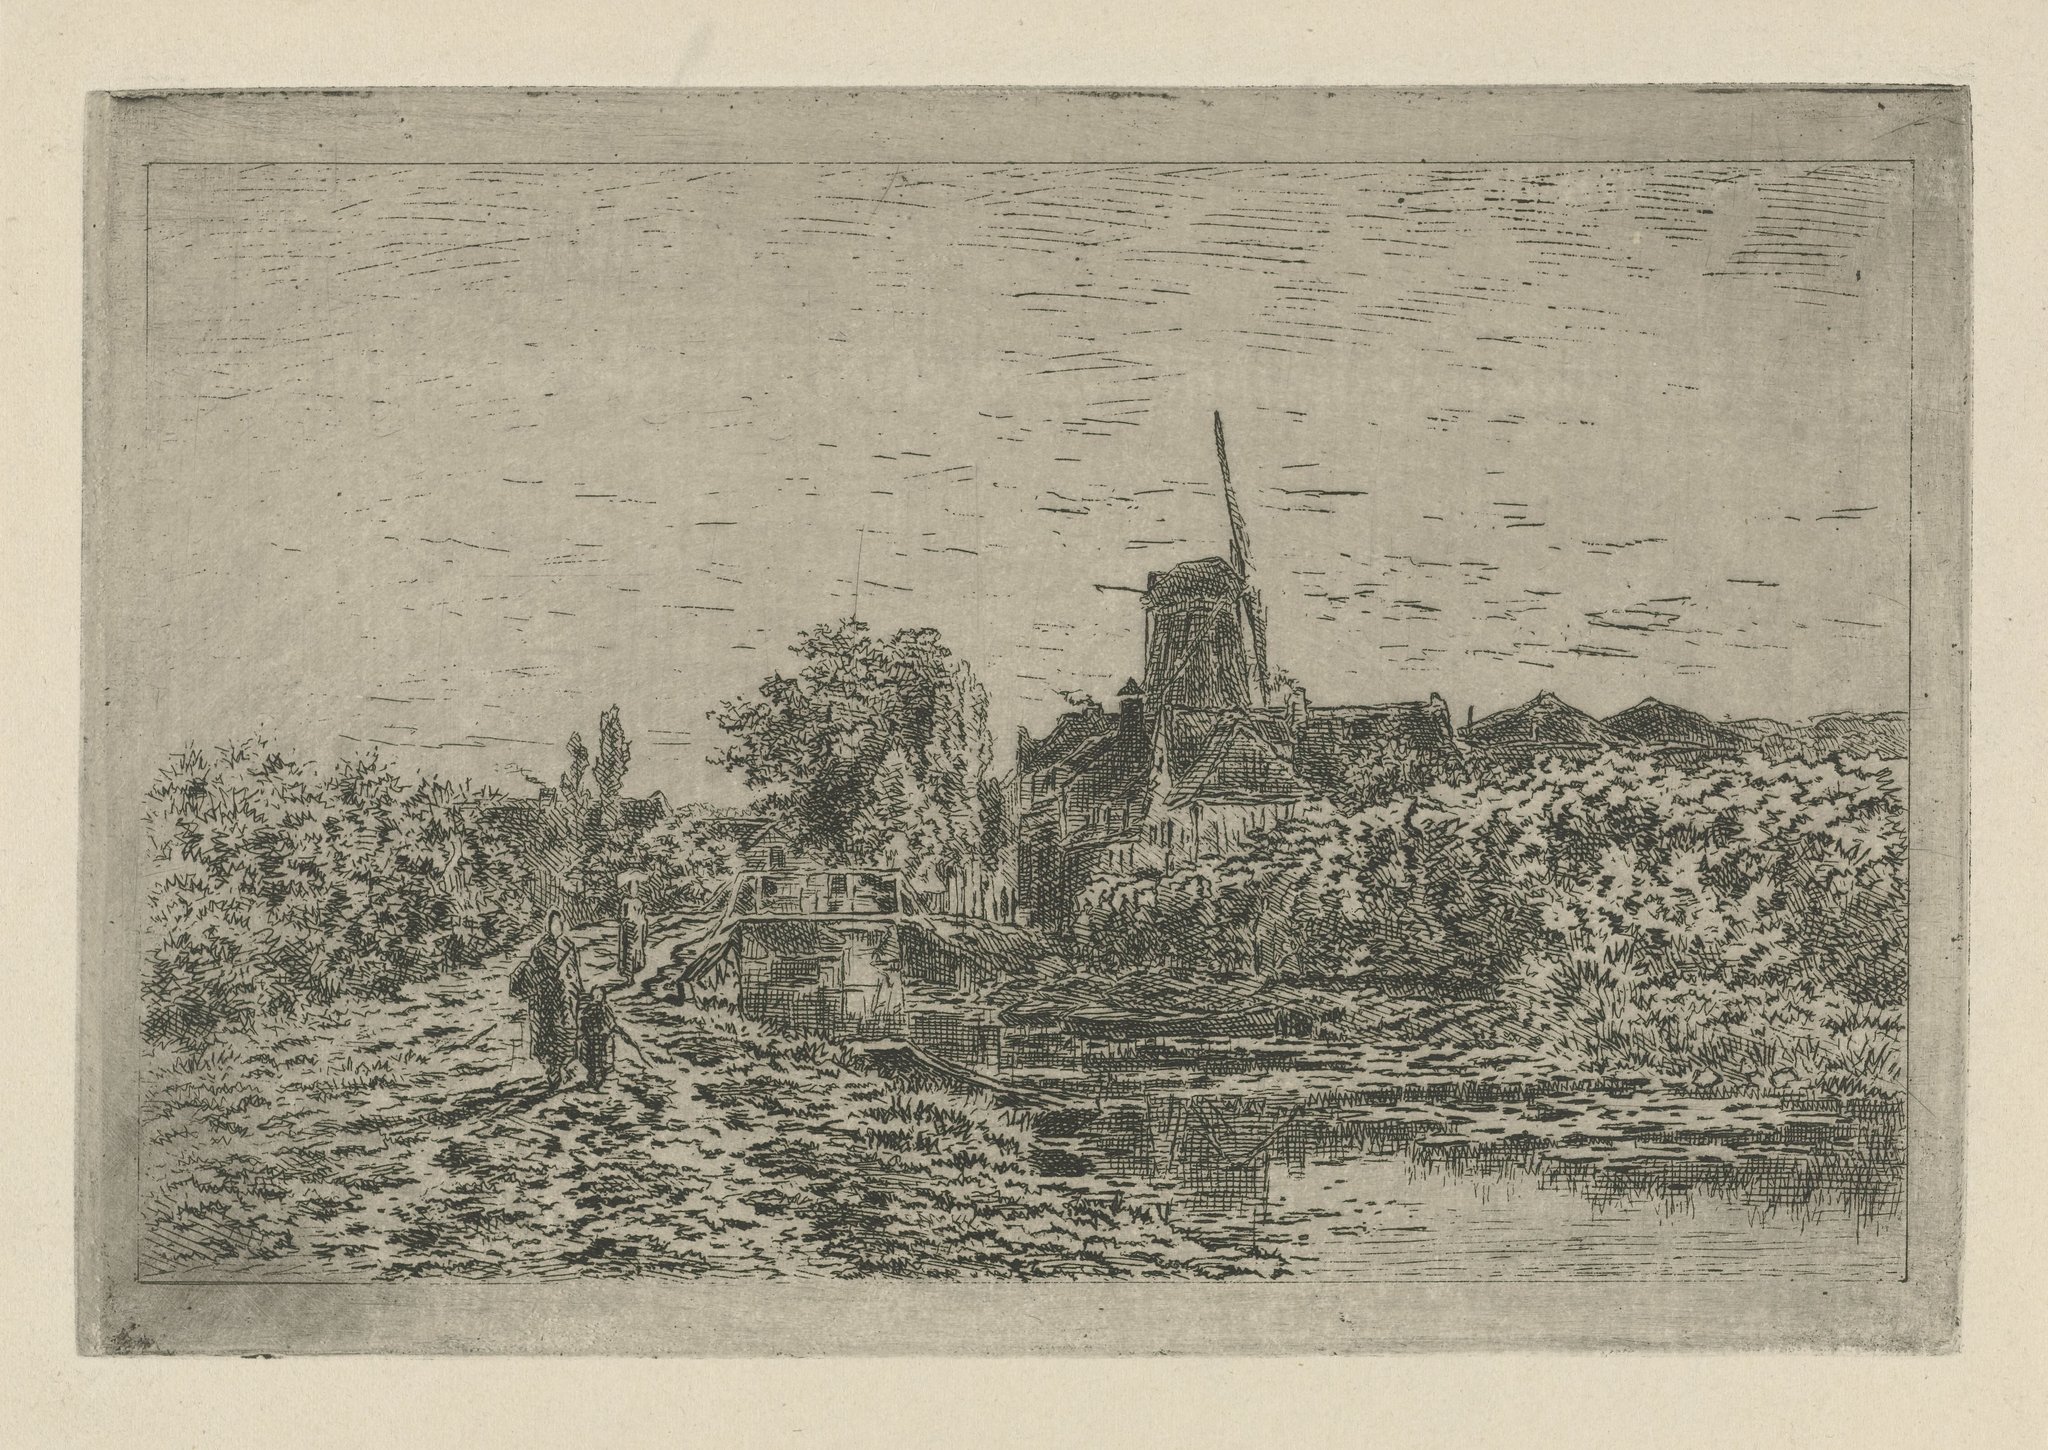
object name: print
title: Landschap met molen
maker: jan van lokhorst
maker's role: draughtsman, print maker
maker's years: 1837-1894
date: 1847-1874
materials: paper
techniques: etching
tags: windmill in landscape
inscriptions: collector's mark: Lugt 2228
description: Landschap met molen, links op de voorgrond lopen figuren langs het water richting een houten brug.